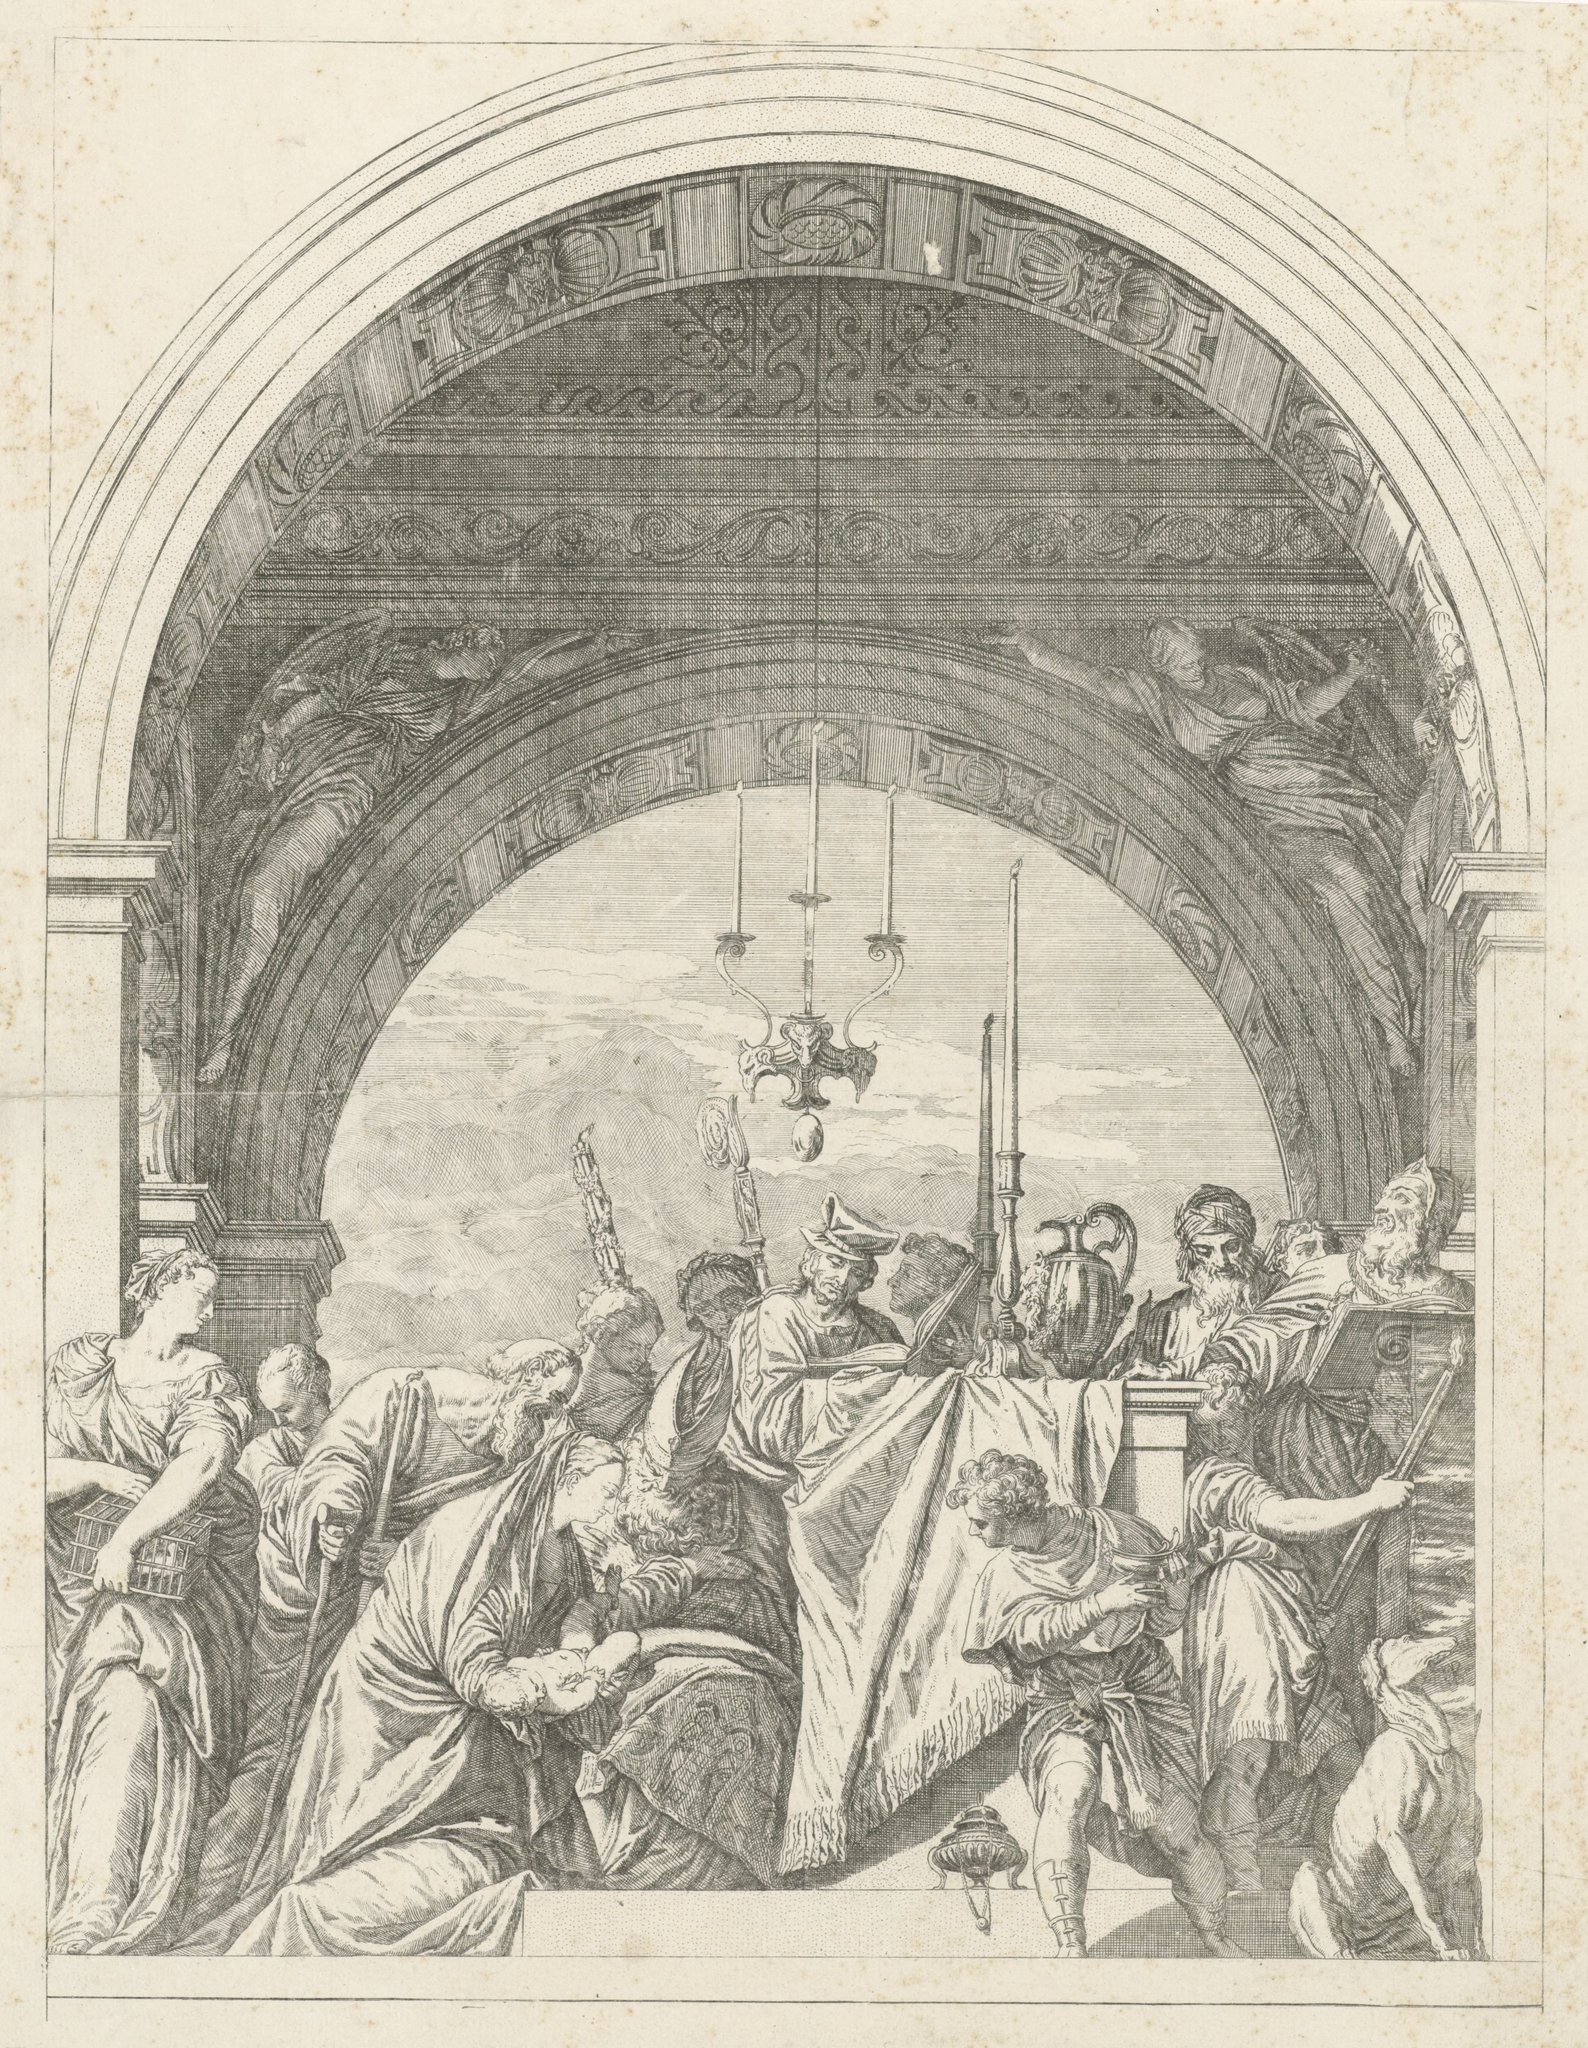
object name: print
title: Opera Selectiora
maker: valentin lefèbvre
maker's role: print maker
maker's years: 1642-1680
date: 1682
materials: paper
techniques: printmaking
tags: presentation of the christ-child in the temple, usually simeon (and anna) present (luke 2:22-39)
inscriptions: collector's mark: Lugt 240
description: In de tempel heeft een groep mensen zich bij het altaar verzameld. De hogepriester Simeon knielt neer voor het Christuskind dat door Maria wordt vastgehouden. Achter Maria kijkt Jozef leunend op zijn staf toe. Uiterst rechts houdt een vrouw een kooitje met twee duiven vast. Tegenafdruk van een prent die deel uitmaakt van een 53-delige serie naar schilderijen van Titiaan en Veronese.